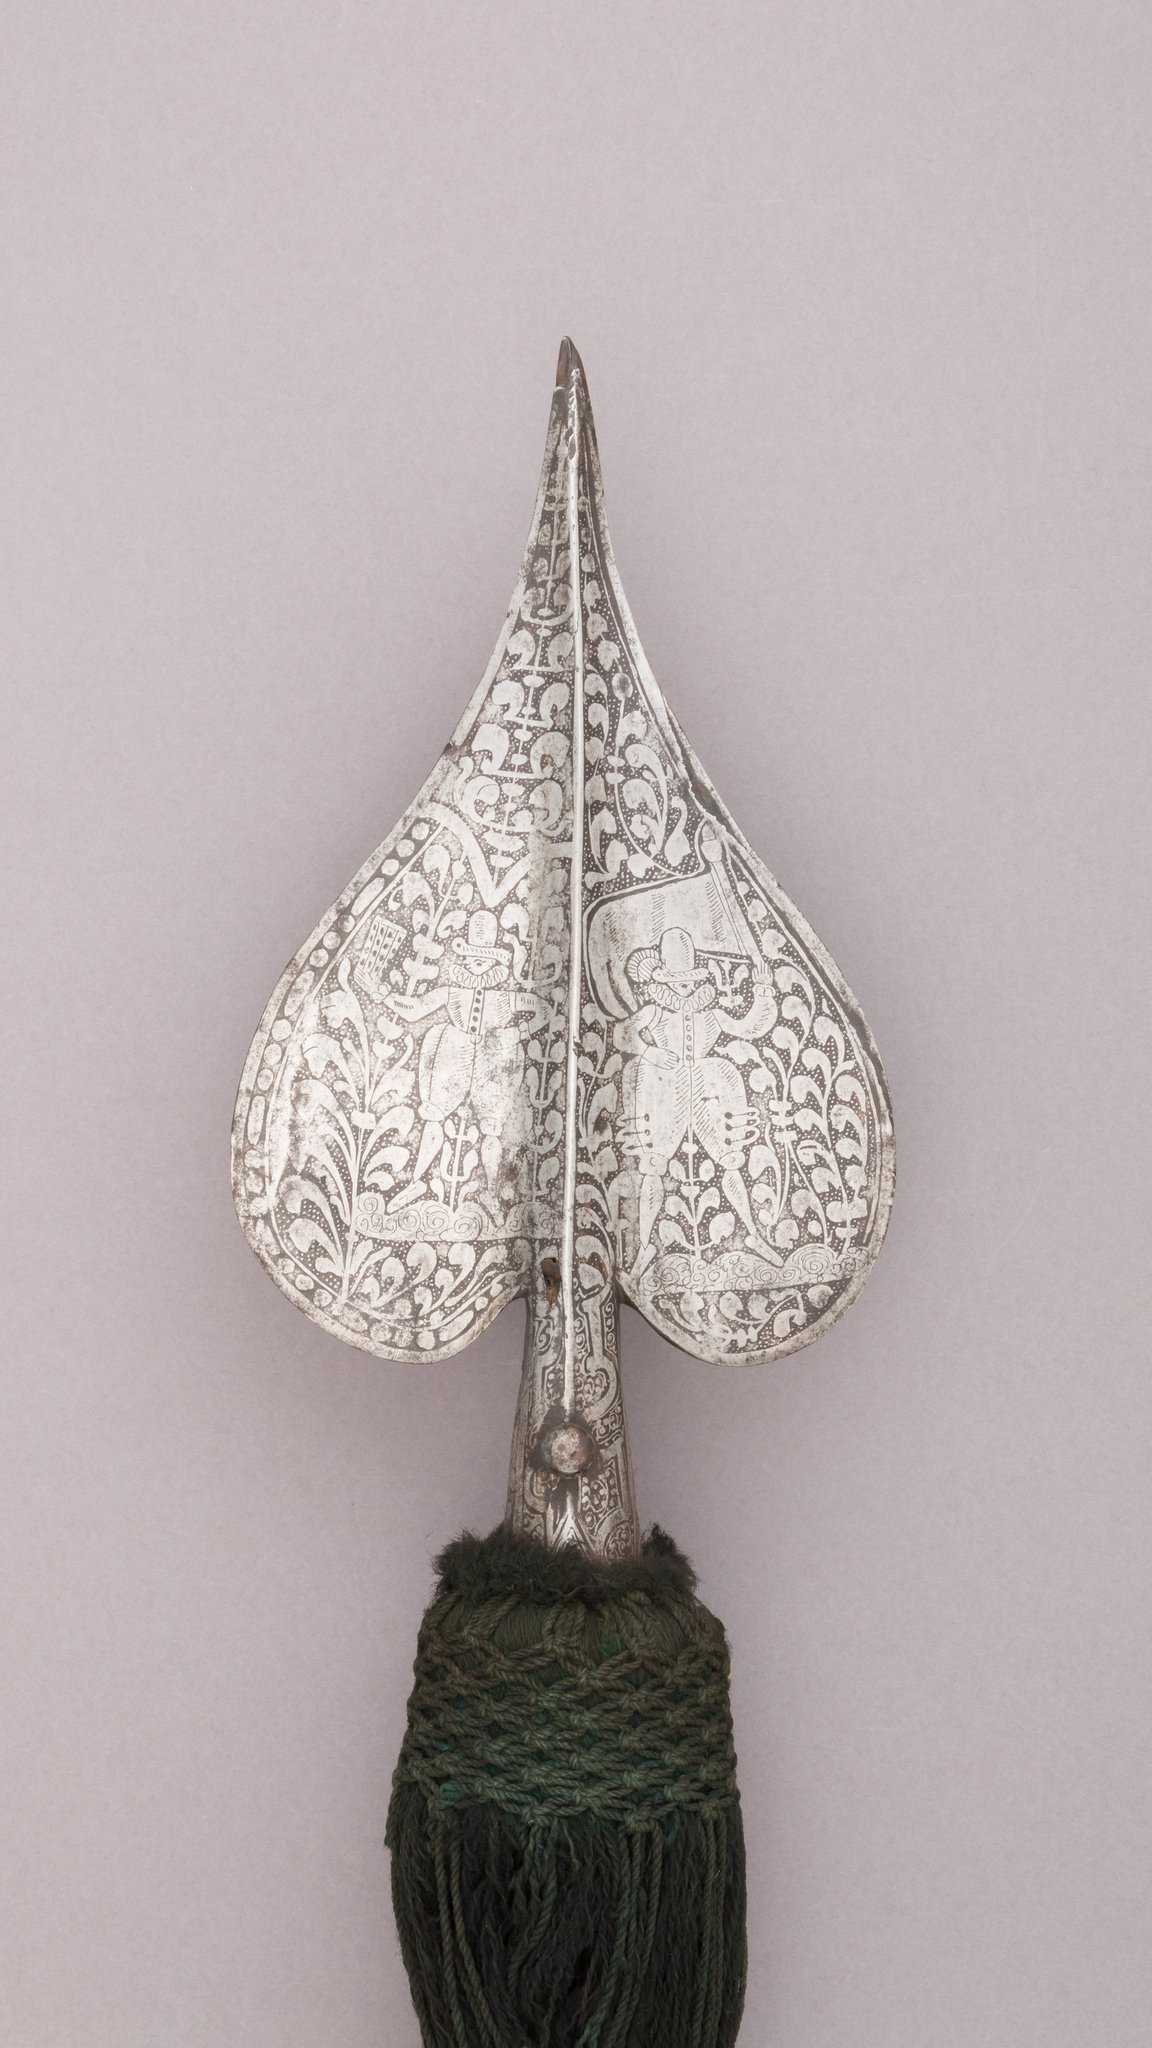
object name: lance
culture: german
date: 1601-1700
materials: steel, textile, wood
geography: germany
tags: men